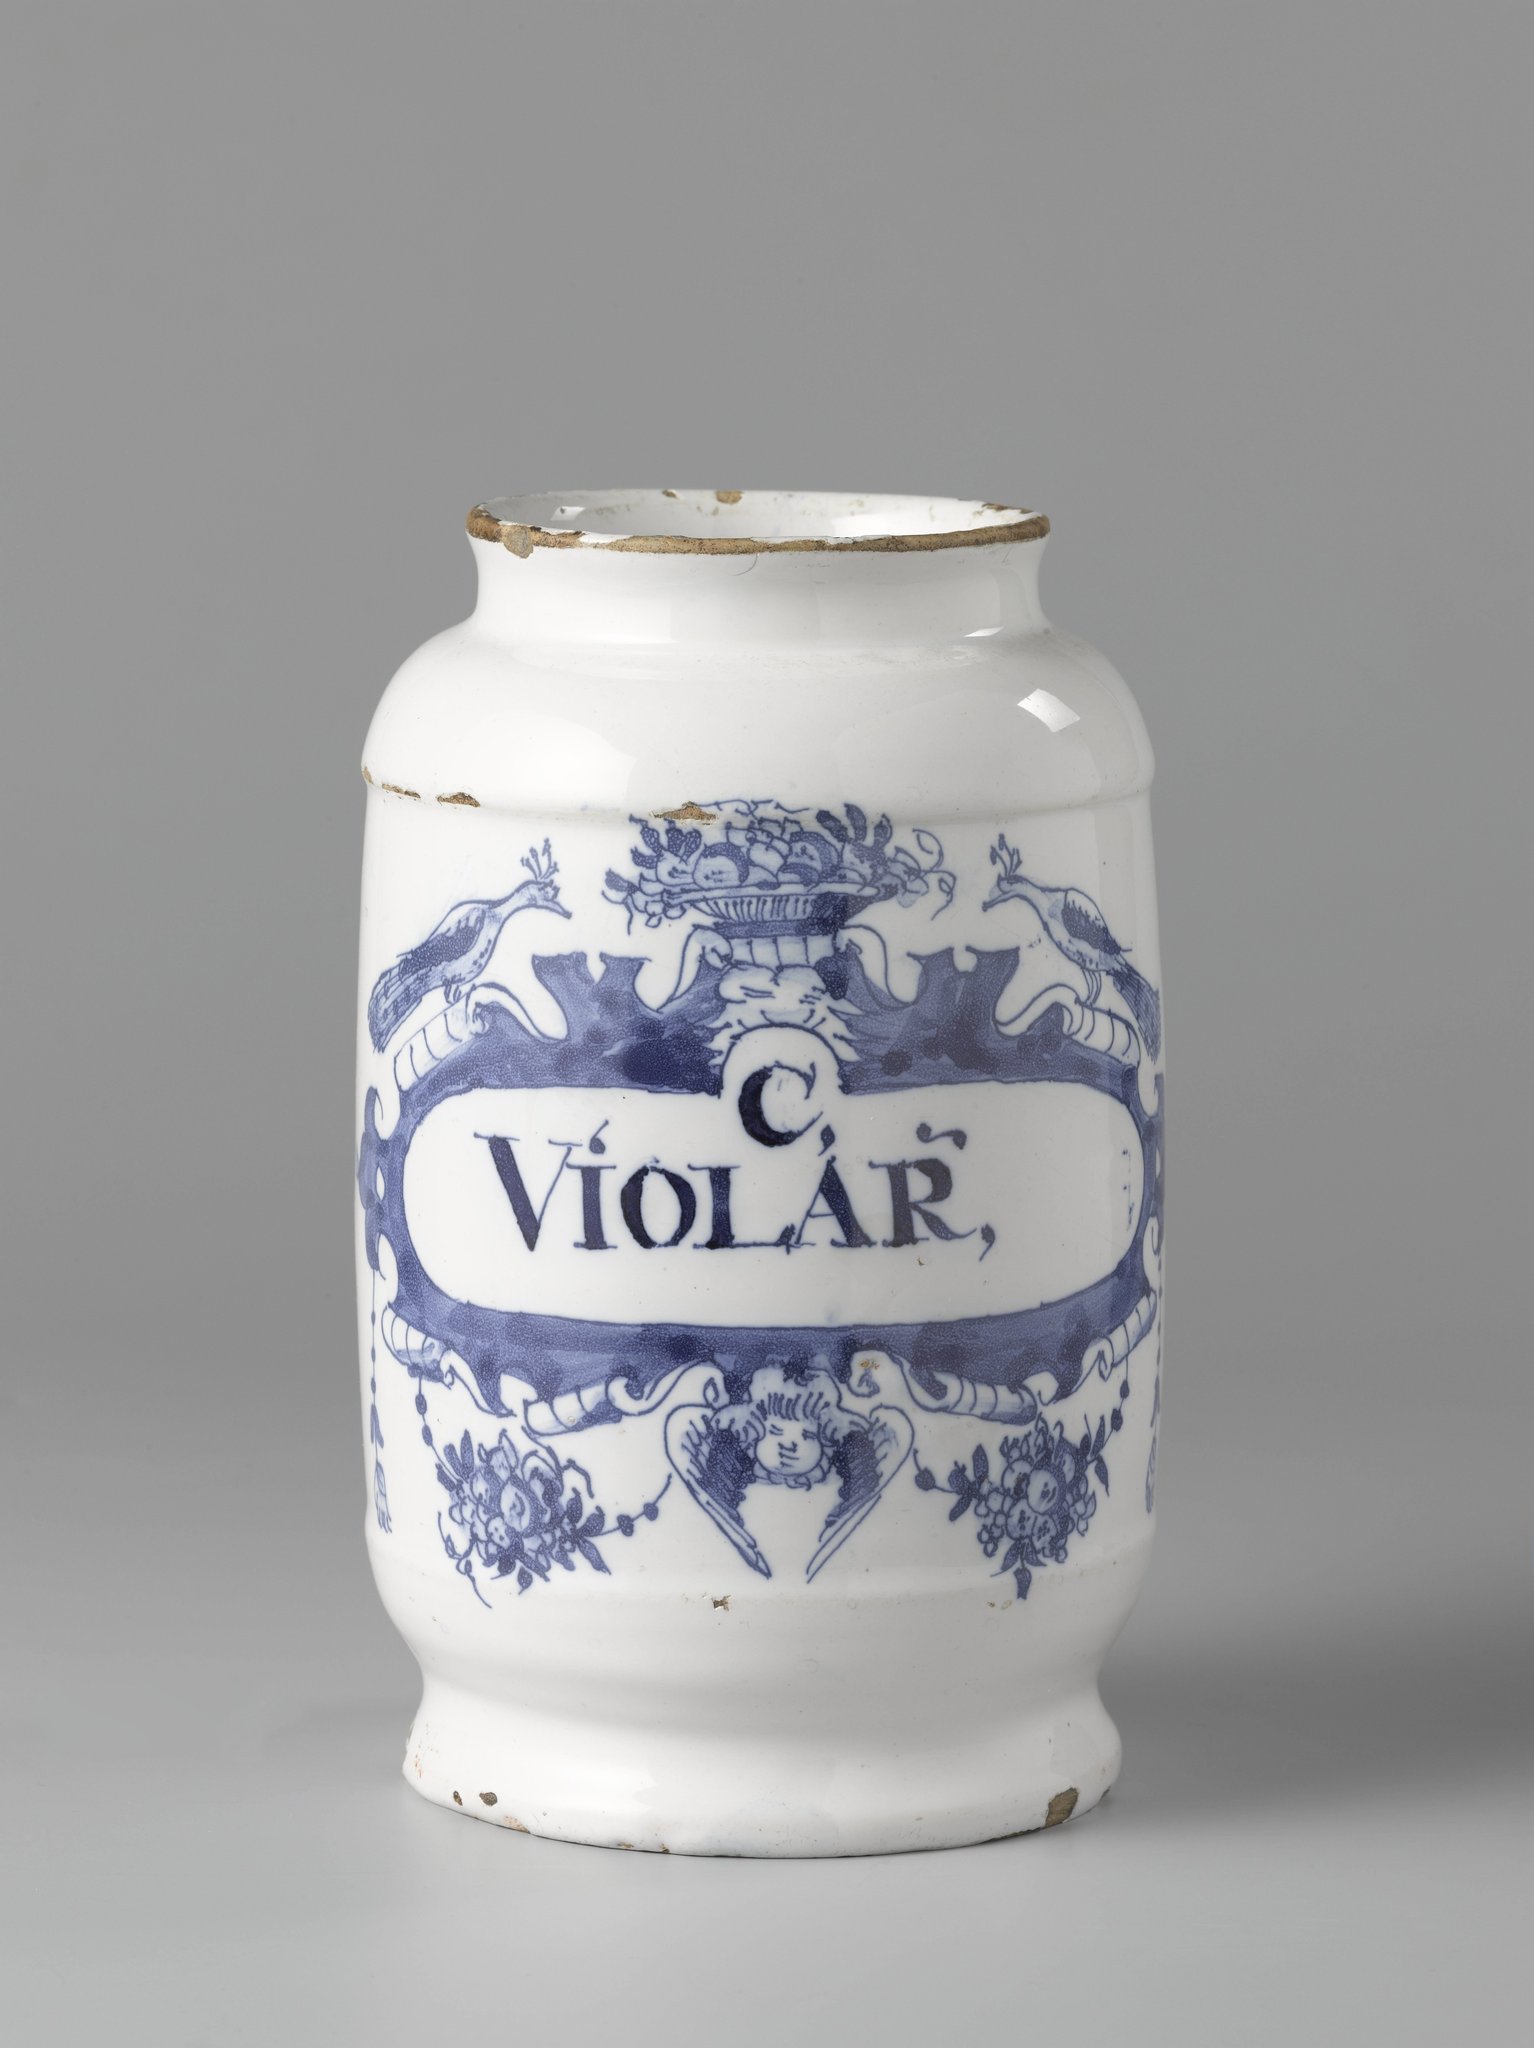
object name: pot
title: Apothekerspot 'C,/ VIOLAR'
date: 1400-1950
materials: earthenware, glaze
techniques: painted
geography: delft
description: Apothekerspot van blauw beschilderde faience met opschrift: C,/ VIOLAR. De cilindrische pot heeft een ingesnoerde voet en hals.